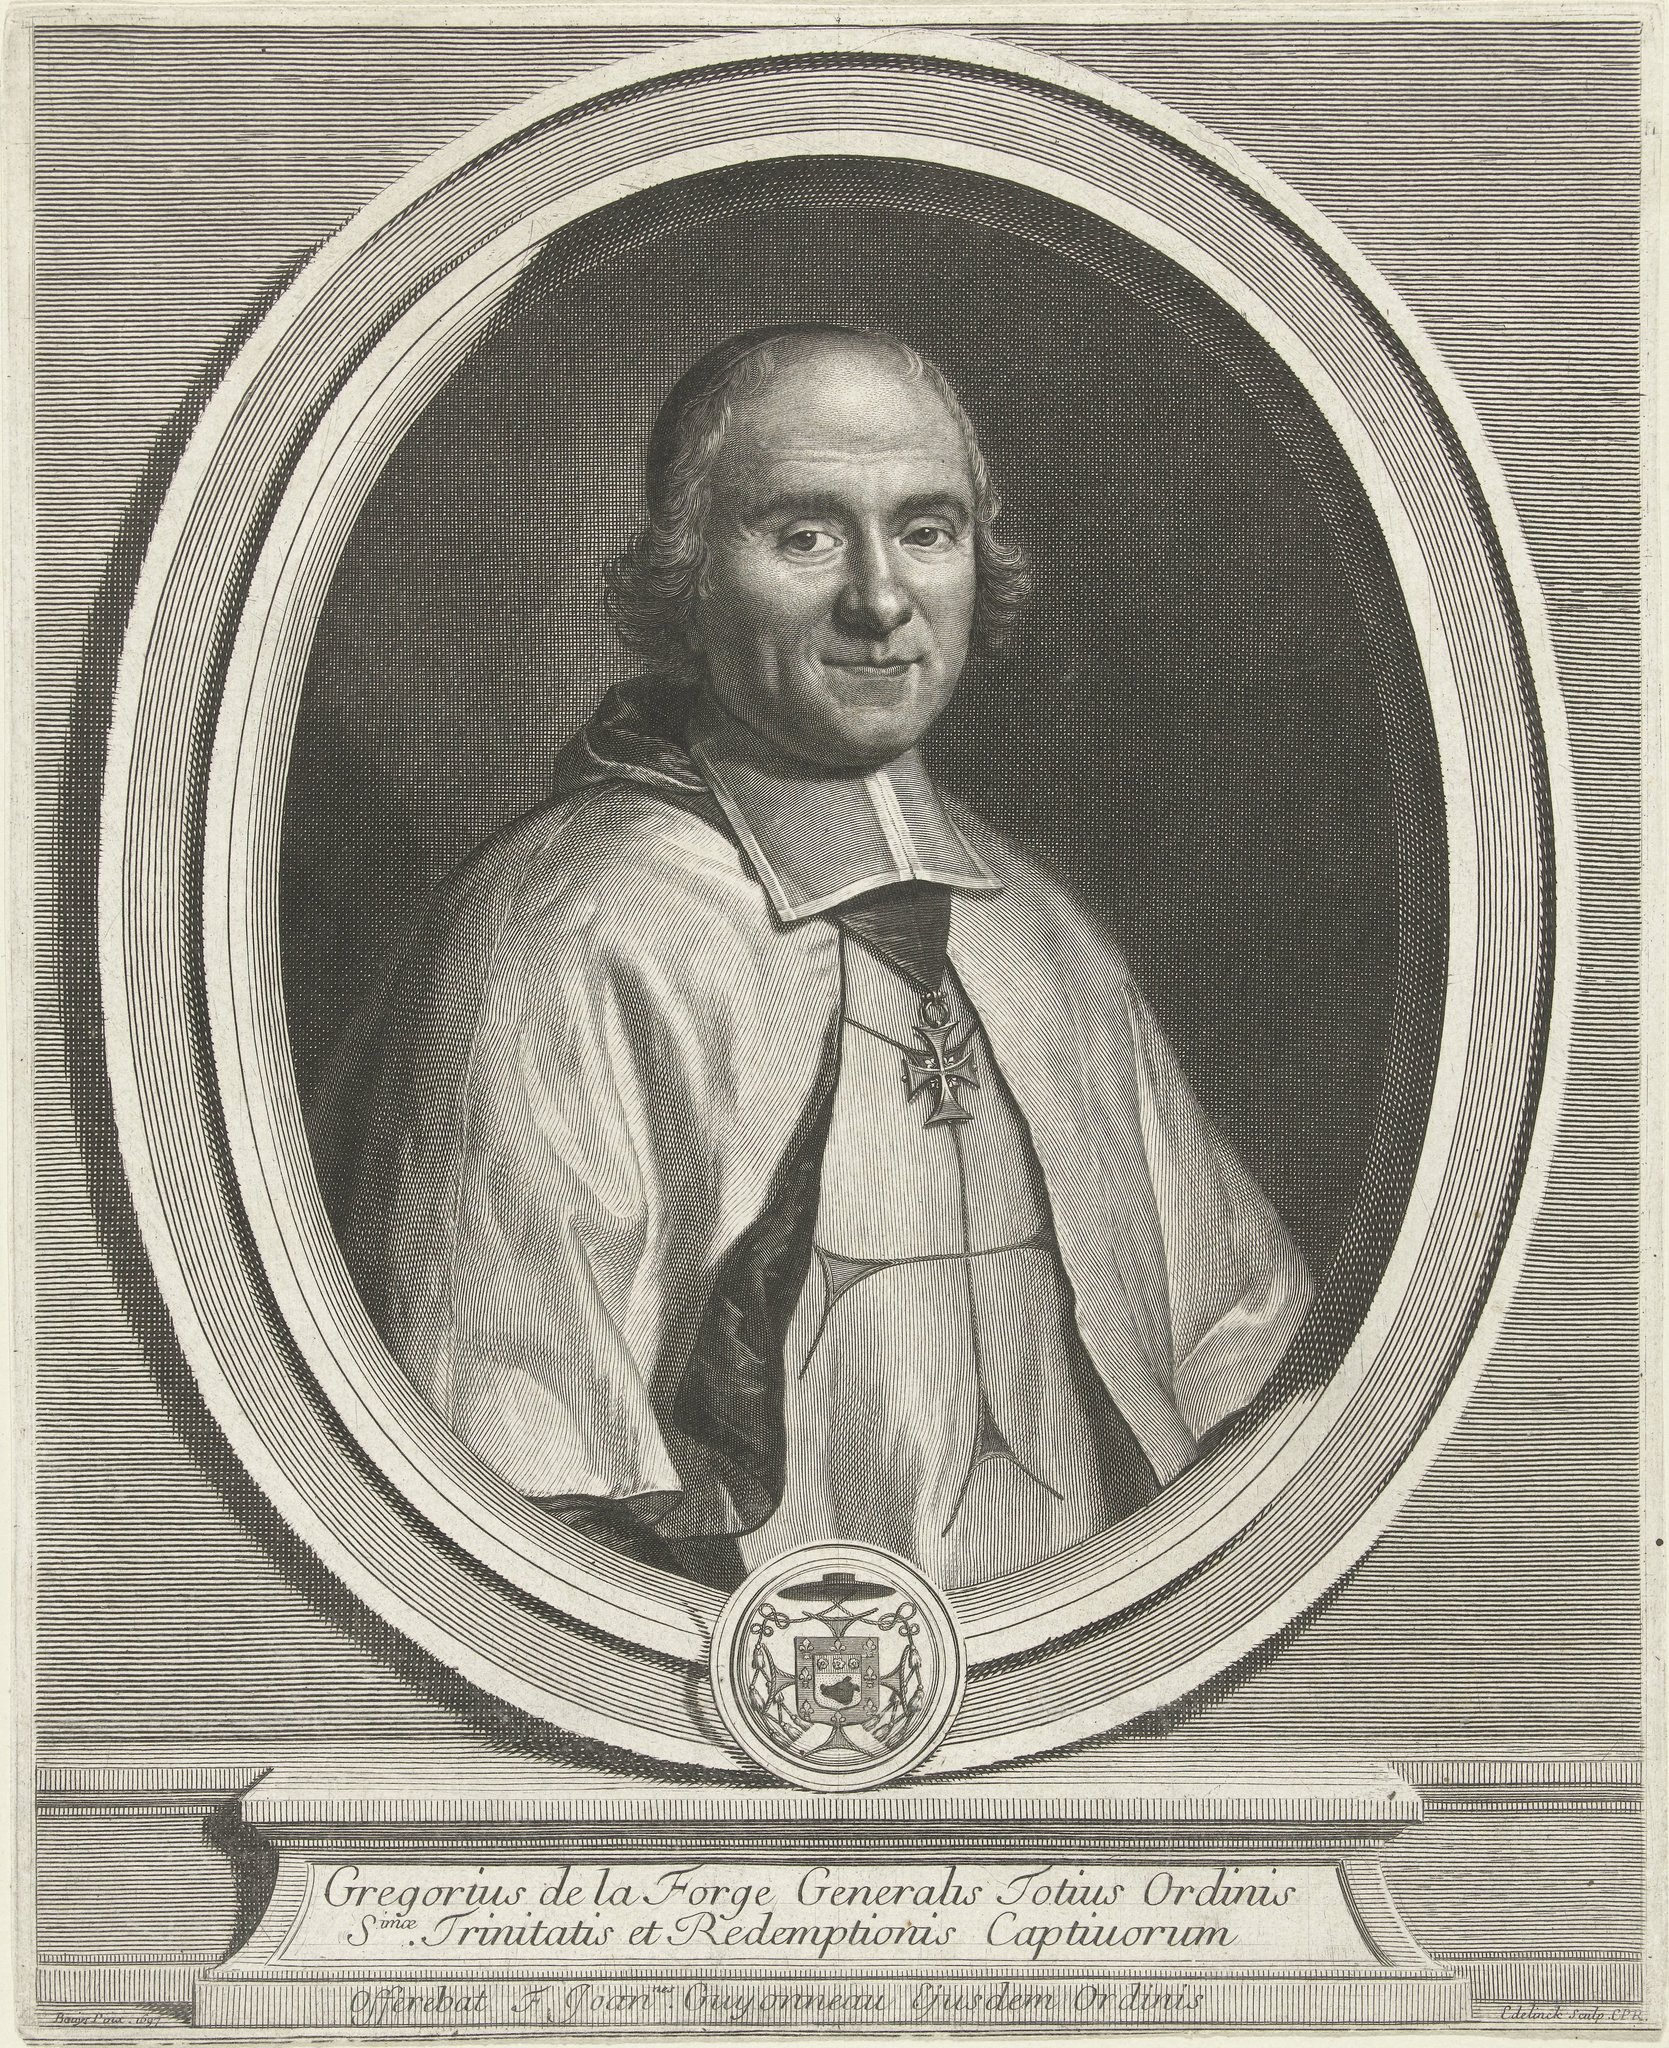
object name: print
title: Portret van Grégoire de la Forge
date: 1697-1707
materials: paper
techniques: engraving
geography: paris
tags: grégoire de la forge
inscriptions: collector's mark: Lugt 240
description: Portret van Grégoire de la Forge, lid van de katholieke bedelorde der Trinitariërs, afgebeeld in ovale omlijsting met wapen, waaronder een console met drie regels Latijnse tekst.